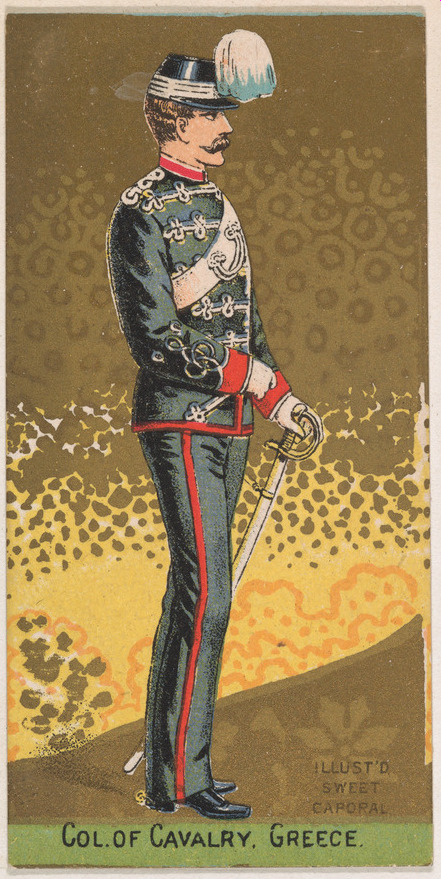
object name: print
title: Colonel of Cavalry, Greece, from the Military Series (N224) issued by Kinney Tobacco Company to promote Sweet Caporal Cigarettes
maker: kinney brothers tobacco company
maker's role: publisher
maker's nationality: american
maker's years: 1869-2011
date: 1888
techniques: color lithograph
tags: military,swords,men,profiles